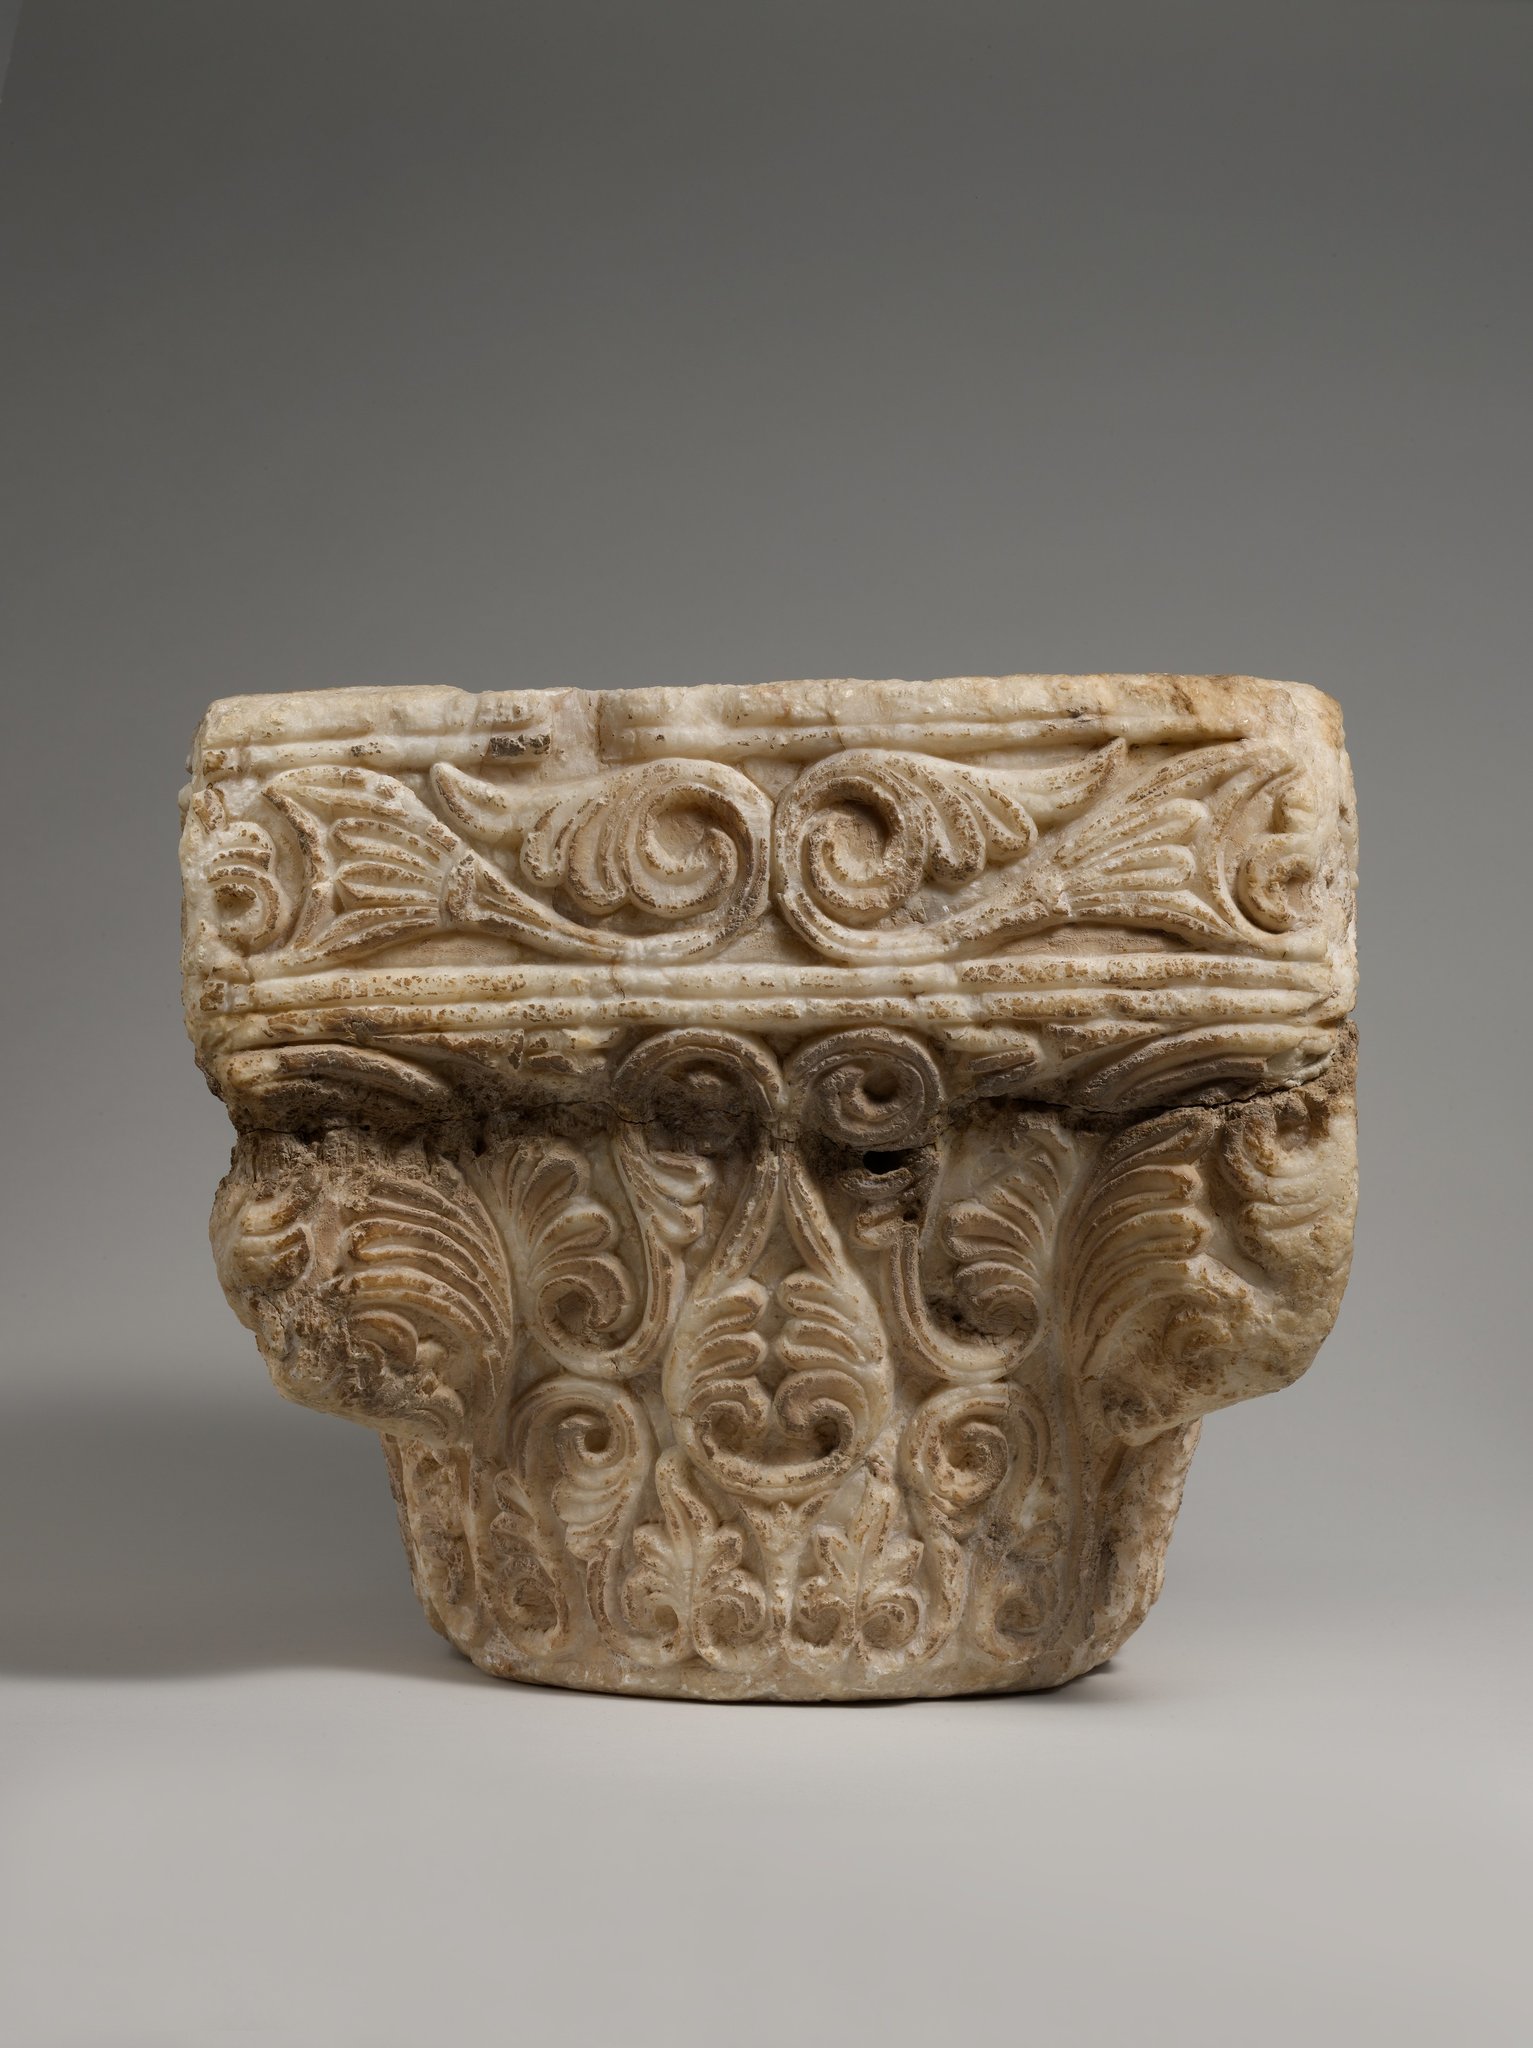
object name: capital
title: Capital with Leaves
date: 767-800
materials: alabaster, gypsum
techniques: carving, relief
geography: syria